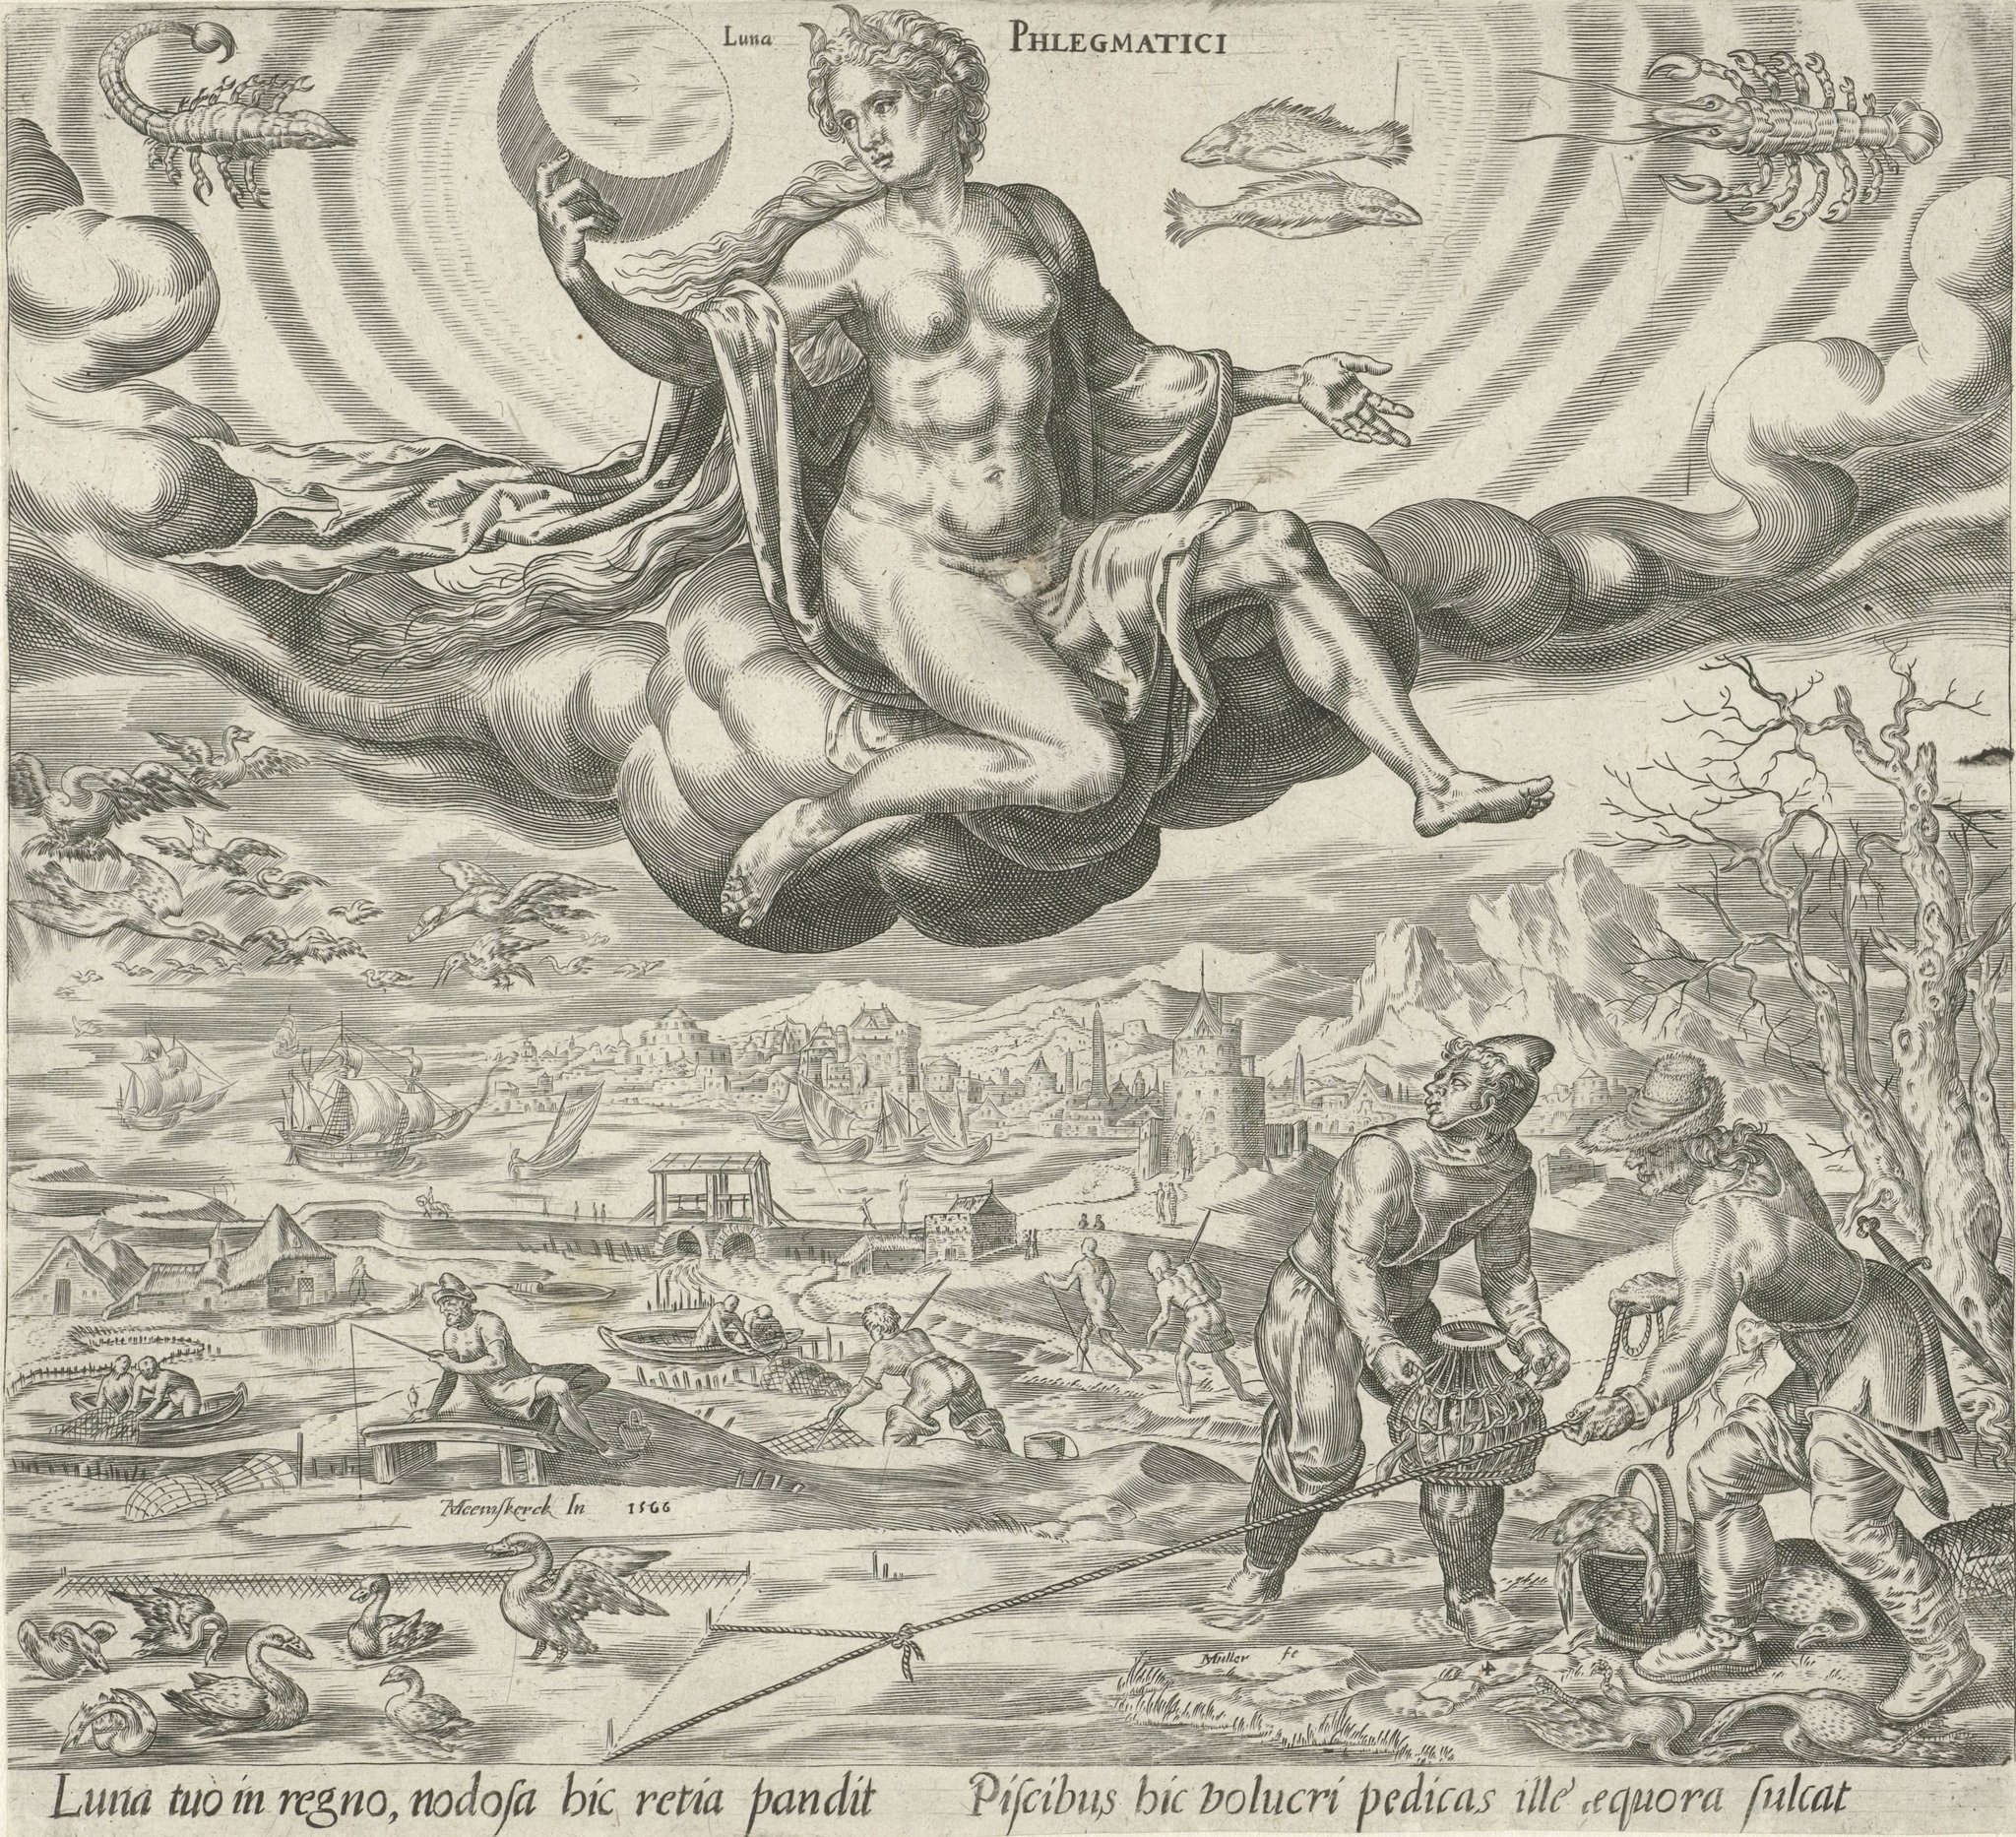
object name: print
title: Phlegmatici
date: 1566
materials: paper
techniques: engraving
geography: antwerp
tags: fresh-water fishery, diana as moon-goddess, i.e. luna (selene), ships (in general), bird hunting, phlegmatic temperament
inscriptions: collector's mark: Lugt 2228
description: Luna, de maan, zit op een wolk en houdt de maansikkel in haar hand. Boven haar staan drie tekens van de zodiak: Schorpioen, Vissen en Kreeft, die passen bij het element water. Onder haar, op aarde, de mensen met een flegmatisch temperament, die door haar geregeerd worden. Rechts staan eendenjagers en op de achtergrond zijn vissers en zeelieden aan het werk. Onderaan in de marge een tekst in het Latijn over de flegmatici en Luna.